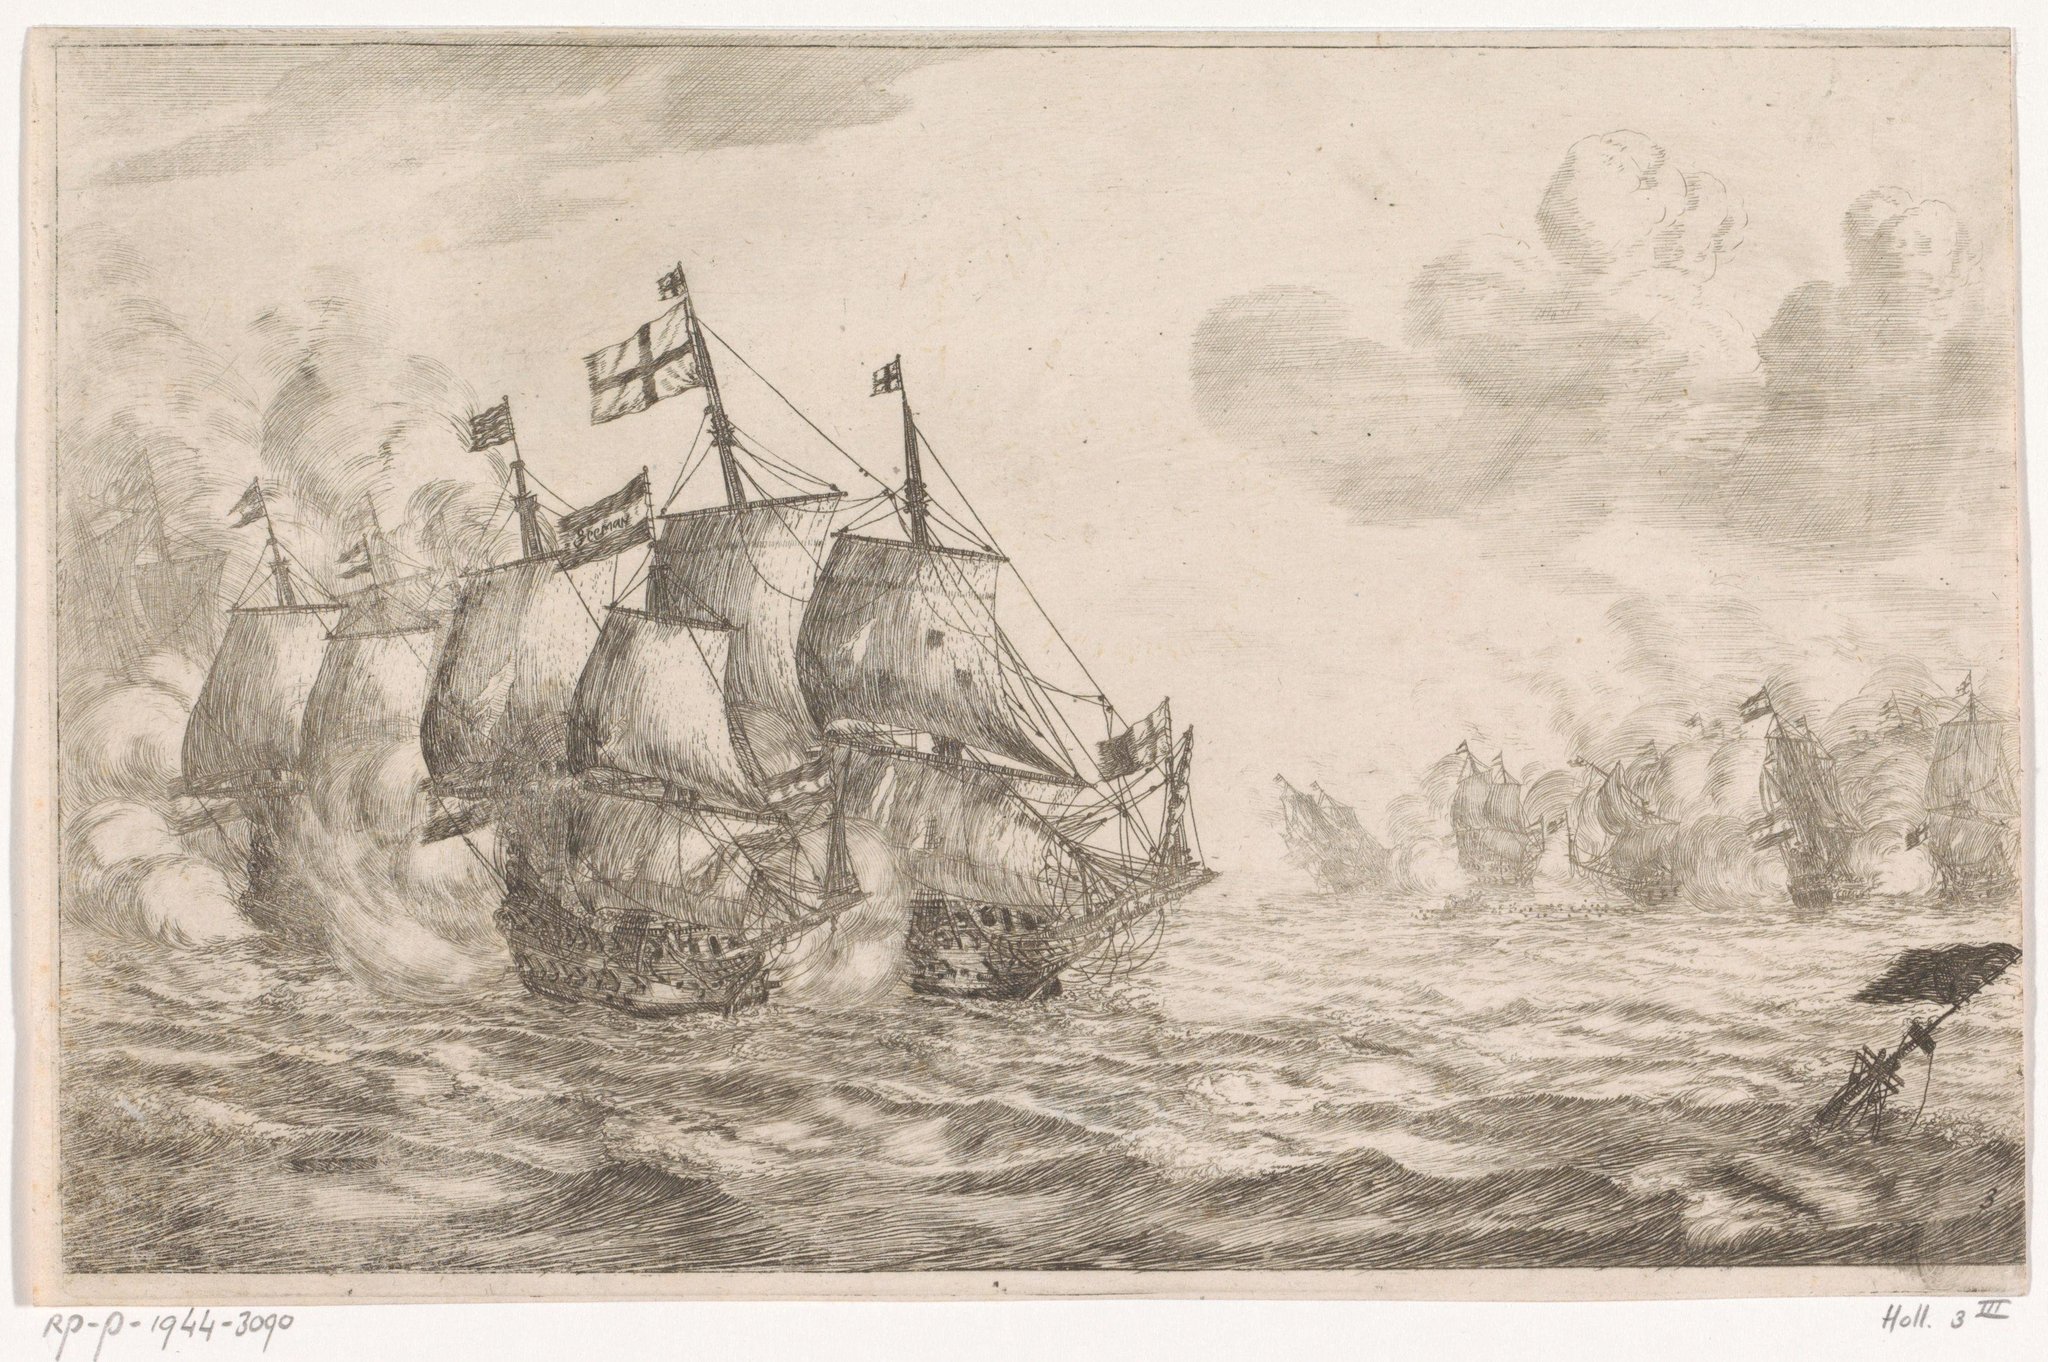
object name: print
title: Zeeslag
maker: reinier nooms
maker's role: draughtsman, painter, print maker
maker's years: 1623-1664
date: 1652-1726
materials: paper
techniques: etching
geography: netherlands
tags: battle (+ naval force), warfare; military affairs (+ sailing-ships)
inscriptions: collector's mark: Lugt 2228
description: Engelse en Hollandse schepen tijdens een zeeslag. Rechts op de voorgrond de mast van een gezonken schip.